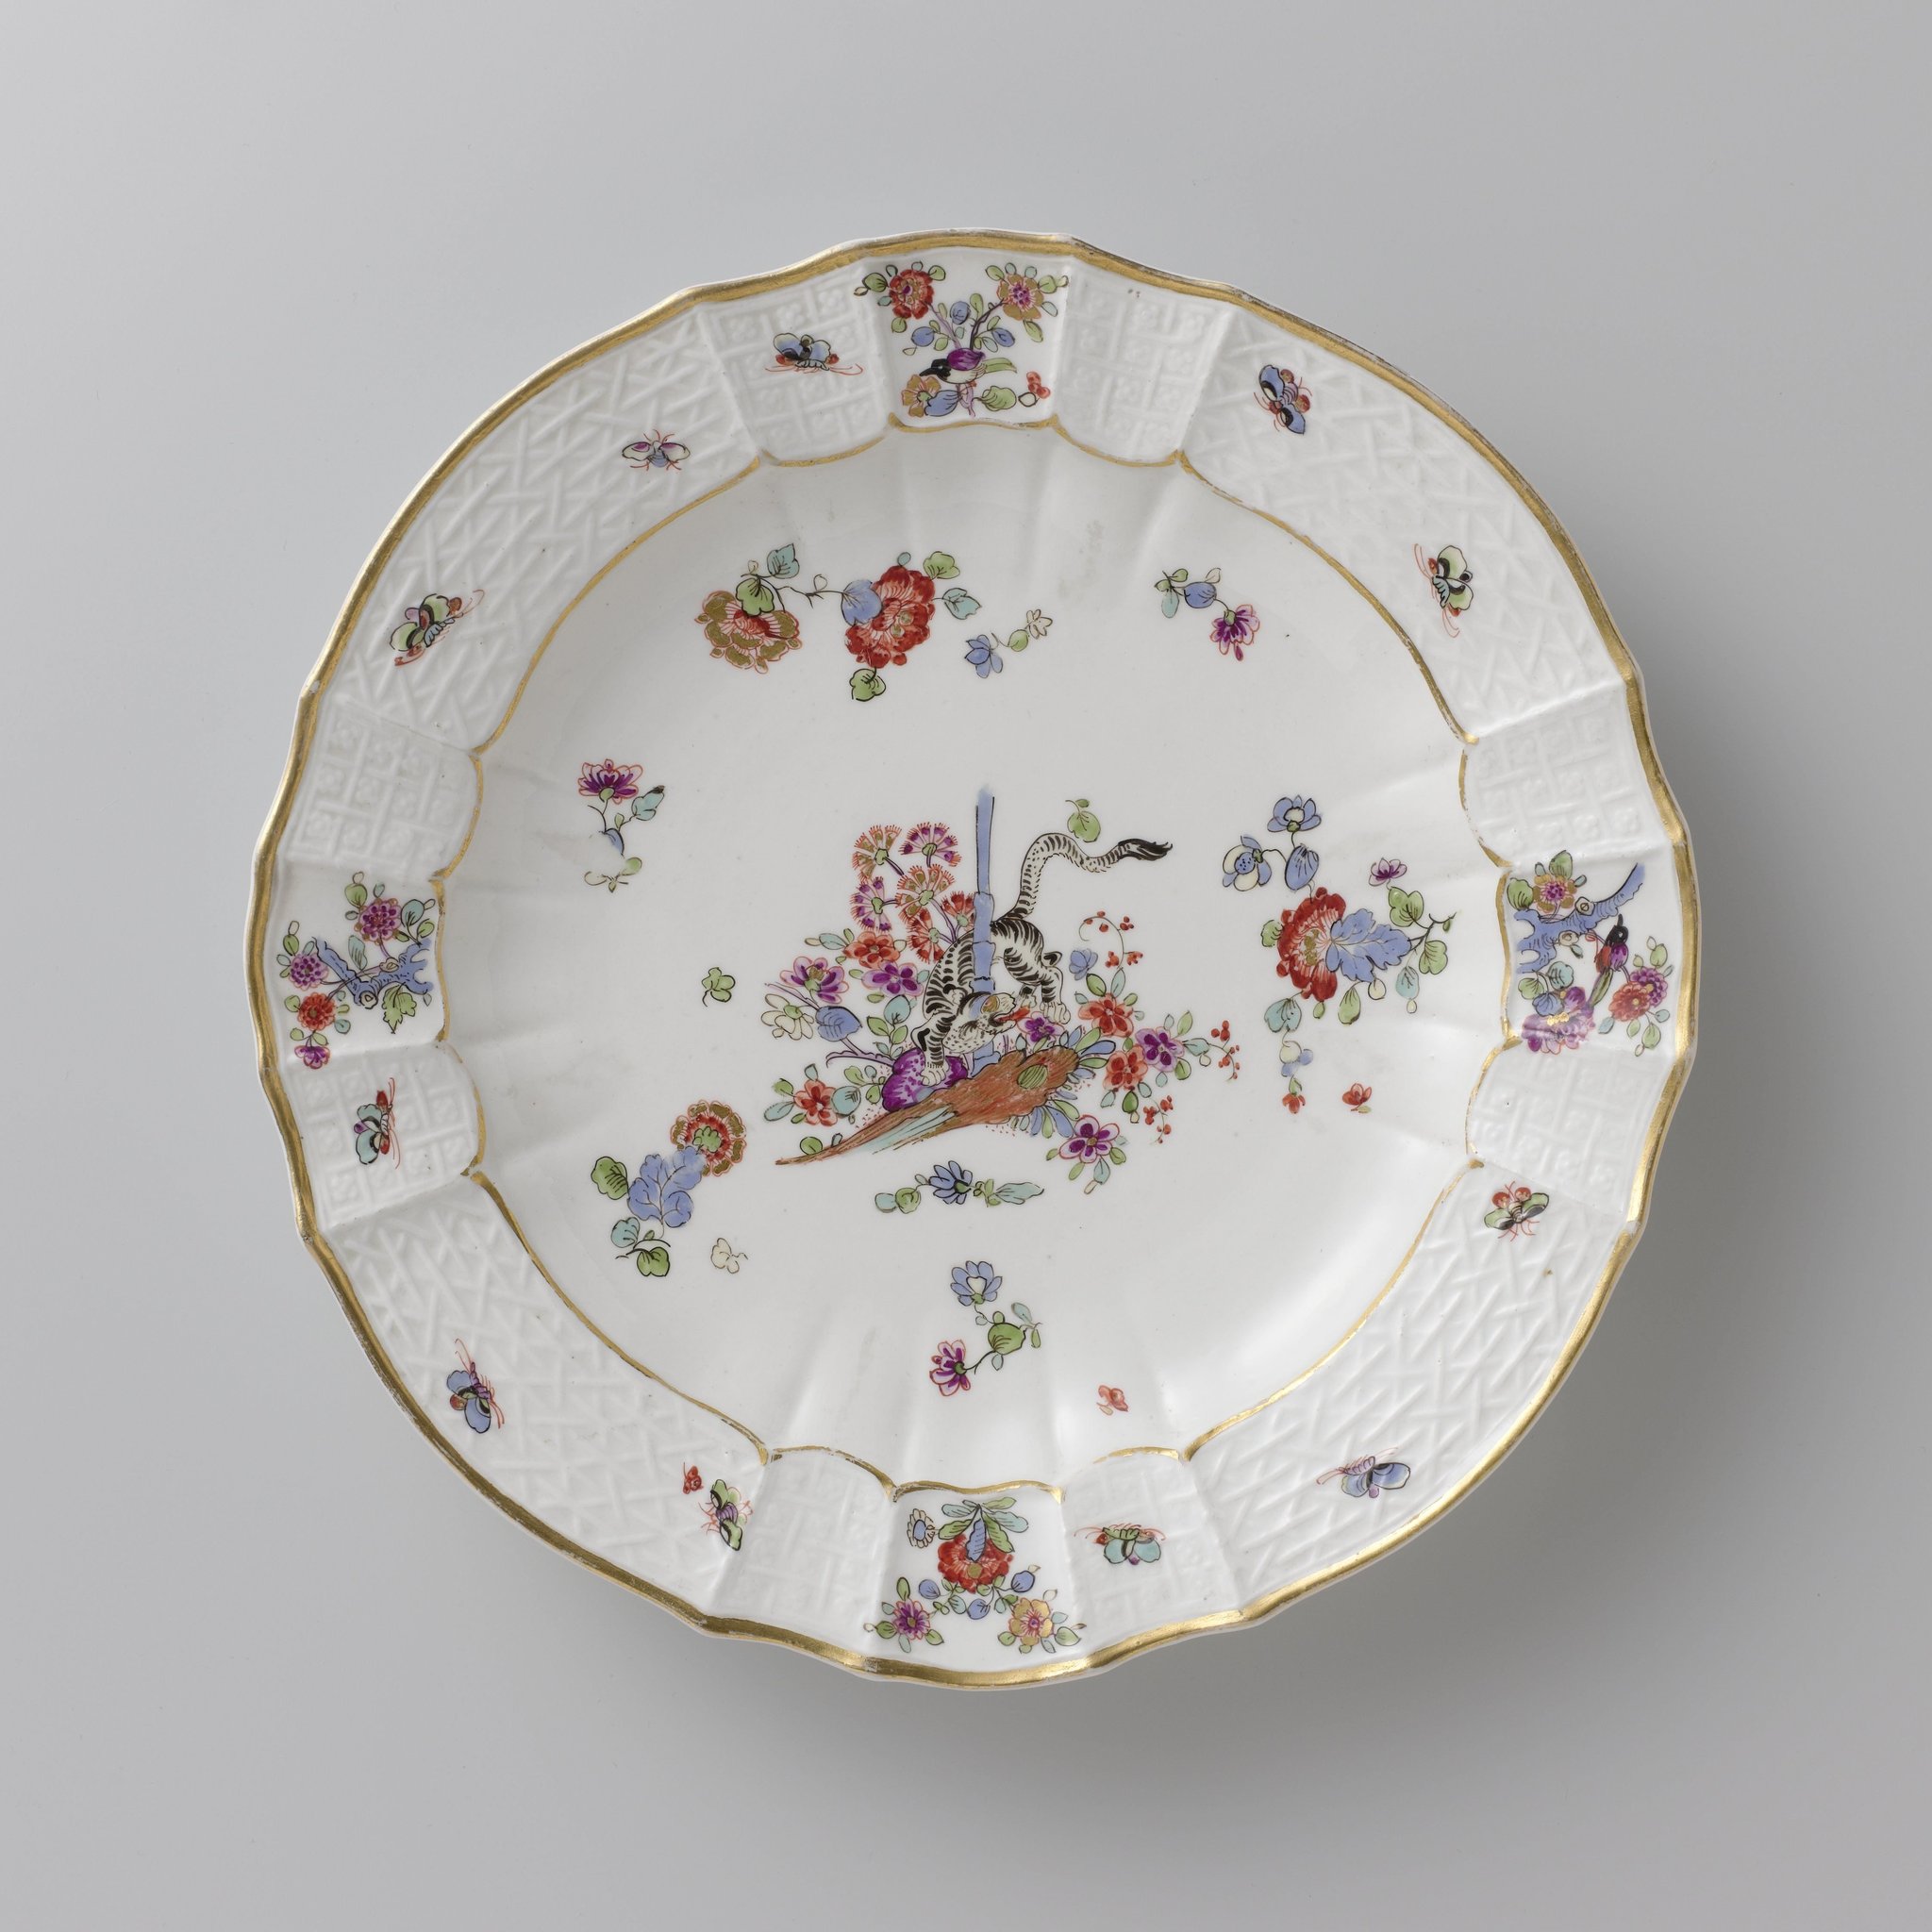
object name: eating drinking utensil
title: Rond bord, veelkleurig beschilderd met een Kakiemon-decor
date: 1740-1745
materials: porcelain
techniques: painted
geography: meissen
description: Rond bord van beschilderd porselein. Het bord is geribd en heeft een geschulpte rand. Het bord is beschilderd met een tijger die om een blauwe bamboestengel tussen bloemen is gedraaid, gestrooide Indianische Blumen, vlinders en takken waarop vogels. De rand is versierd met het 'Altbrandenstein'-patroon. Het bord is gemerkt.